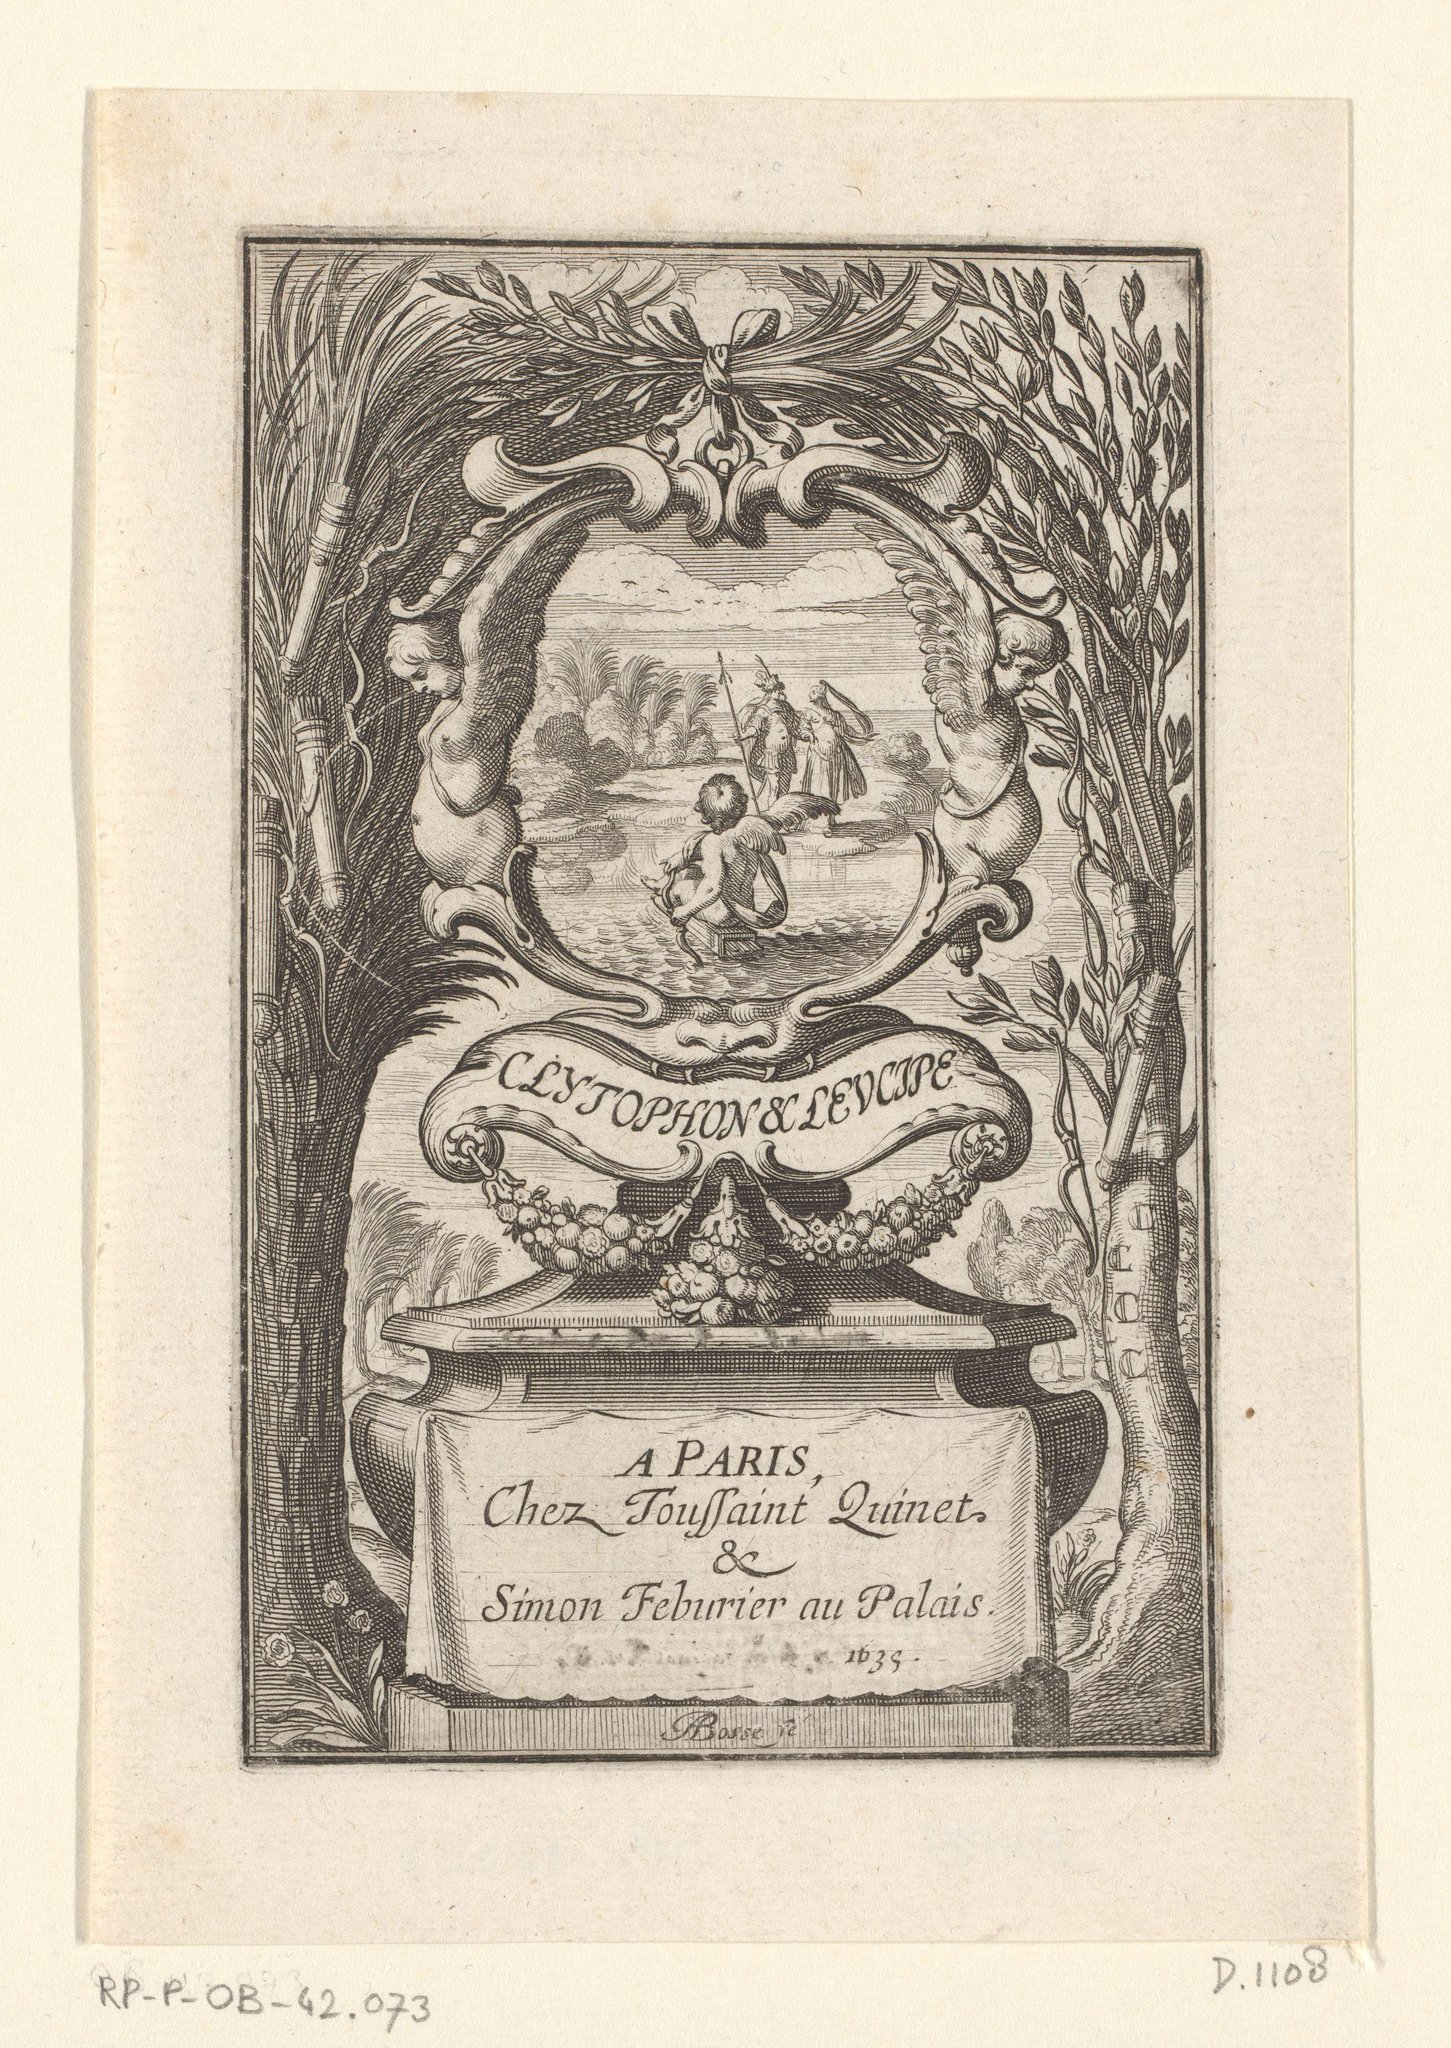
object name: print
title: Cartouche met een Amor drijvend op zijn pijlenkoker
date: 1635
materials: paper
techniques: engraving, etching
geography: paris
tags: ornament ~ cartouche, cupids: 'amores', 'amoretti', 'putti'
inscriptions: collector's mark: Lugt 240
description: Titelpagina voor: Achilles Tatius, Les Amours de Clytophon. Parijs: Fevrier, Simon en Toussaint Quinet, 1635.